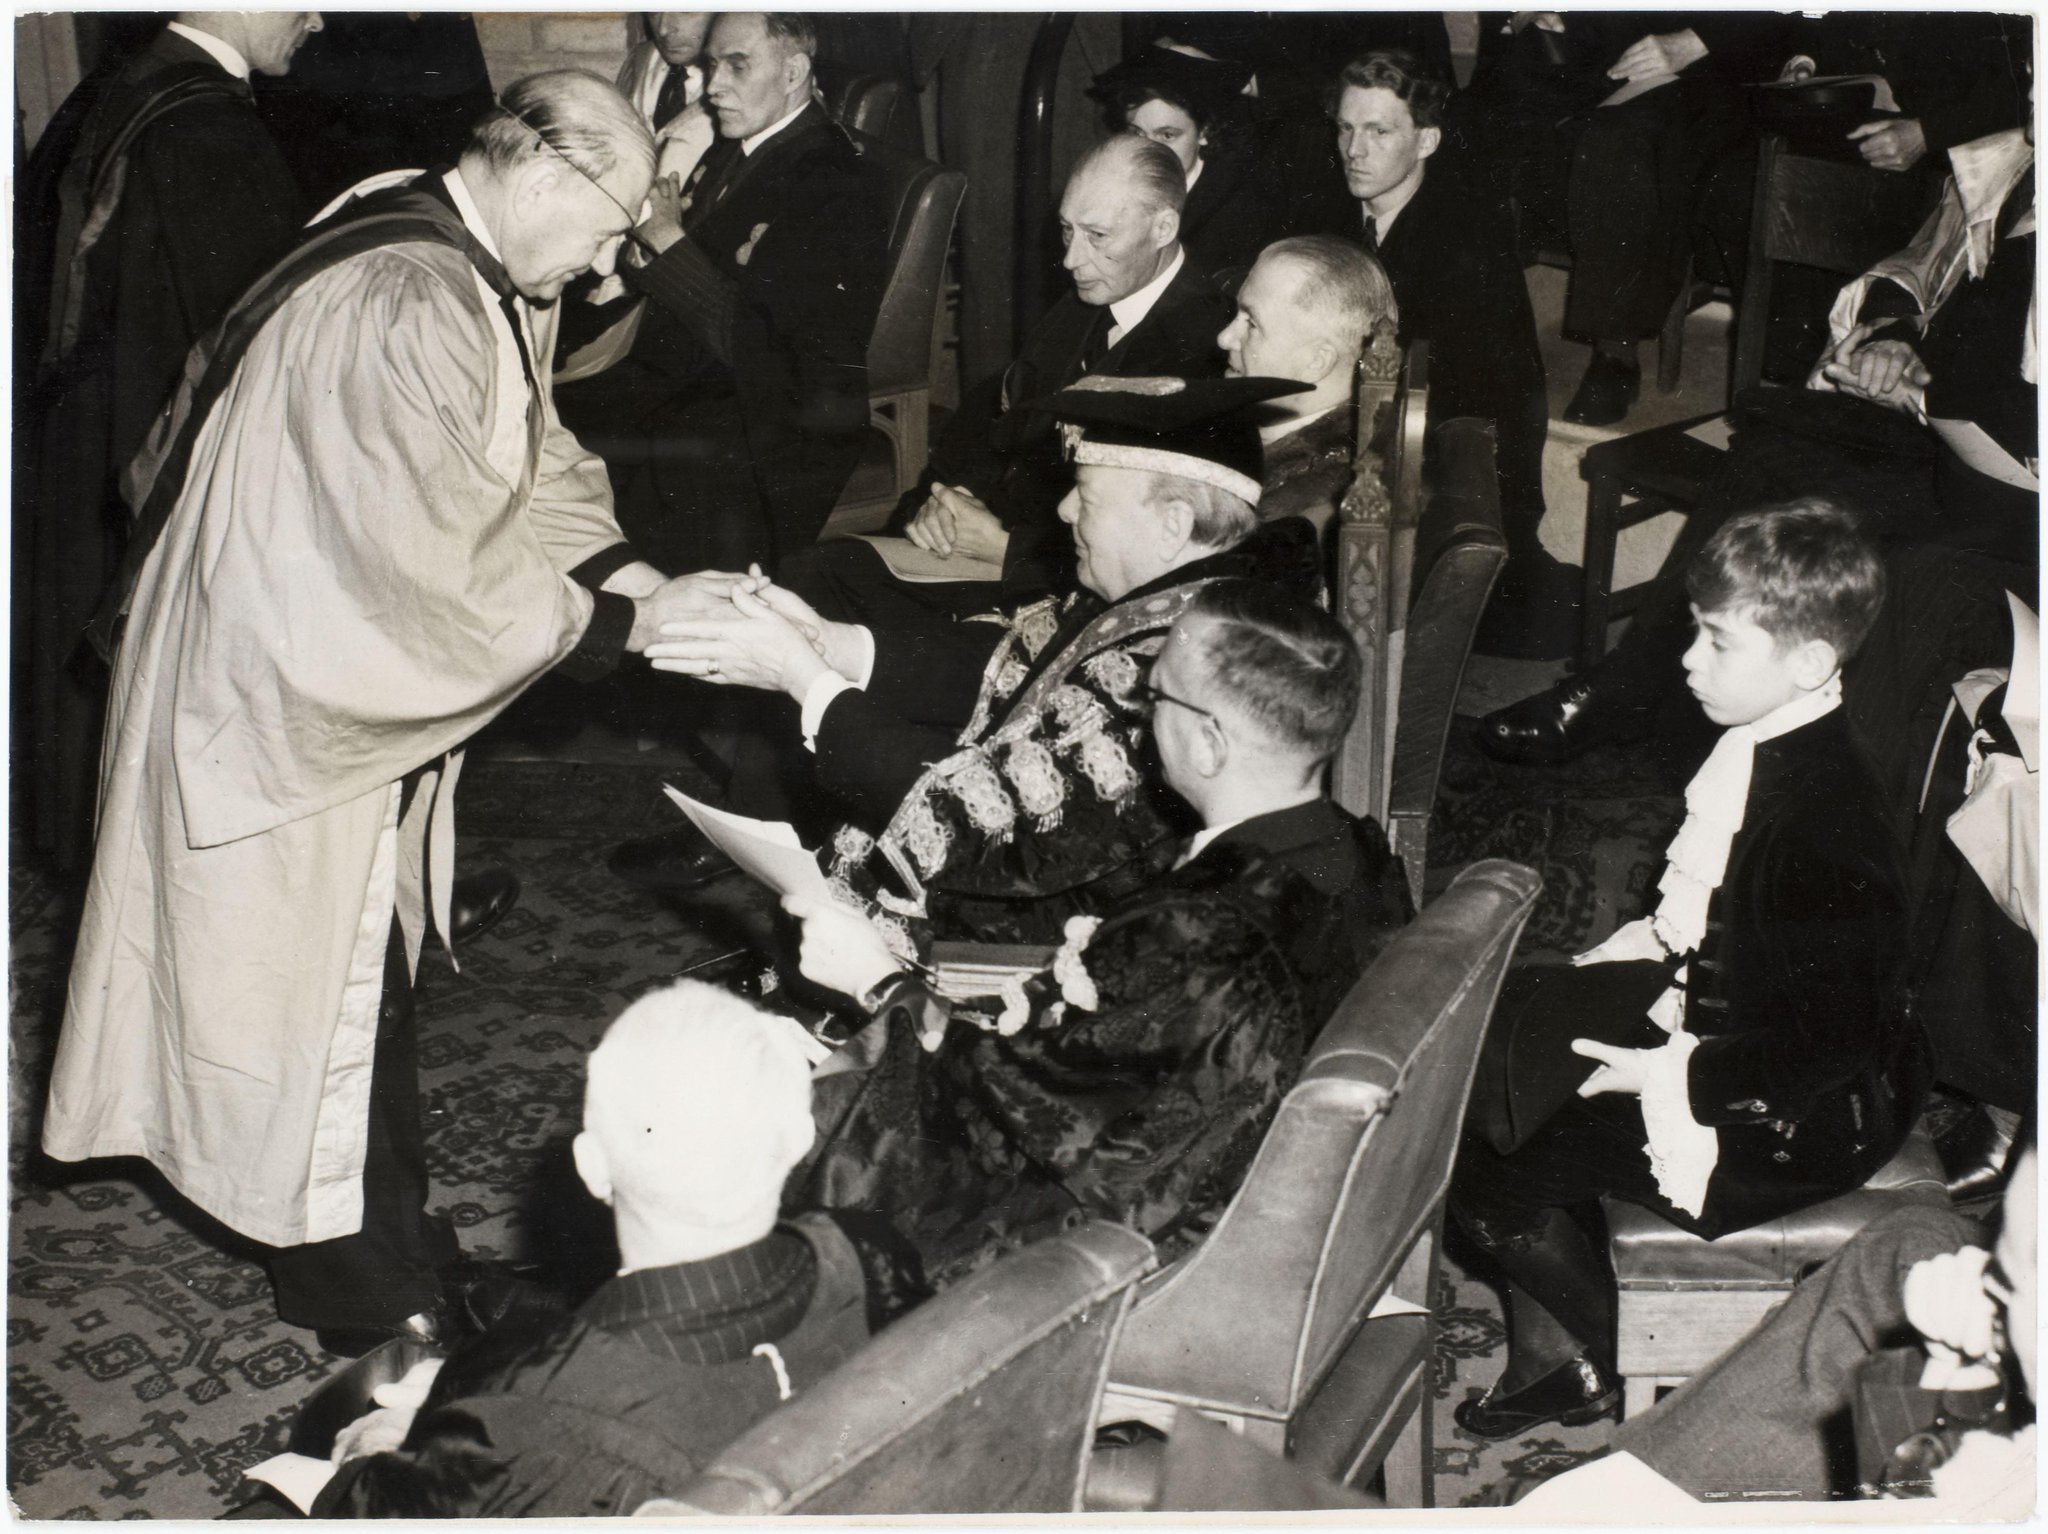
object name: photograph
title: Winston Churchill presenteert eredoctoraat aan Amerikaanse ambassadeur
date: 1949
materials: photographic support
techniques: gelatin silver print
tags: staatsman, sir winston leonard spencer churchill, bristol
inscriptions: stamp: ‘Copyright photo press Belgium S.A. ...’